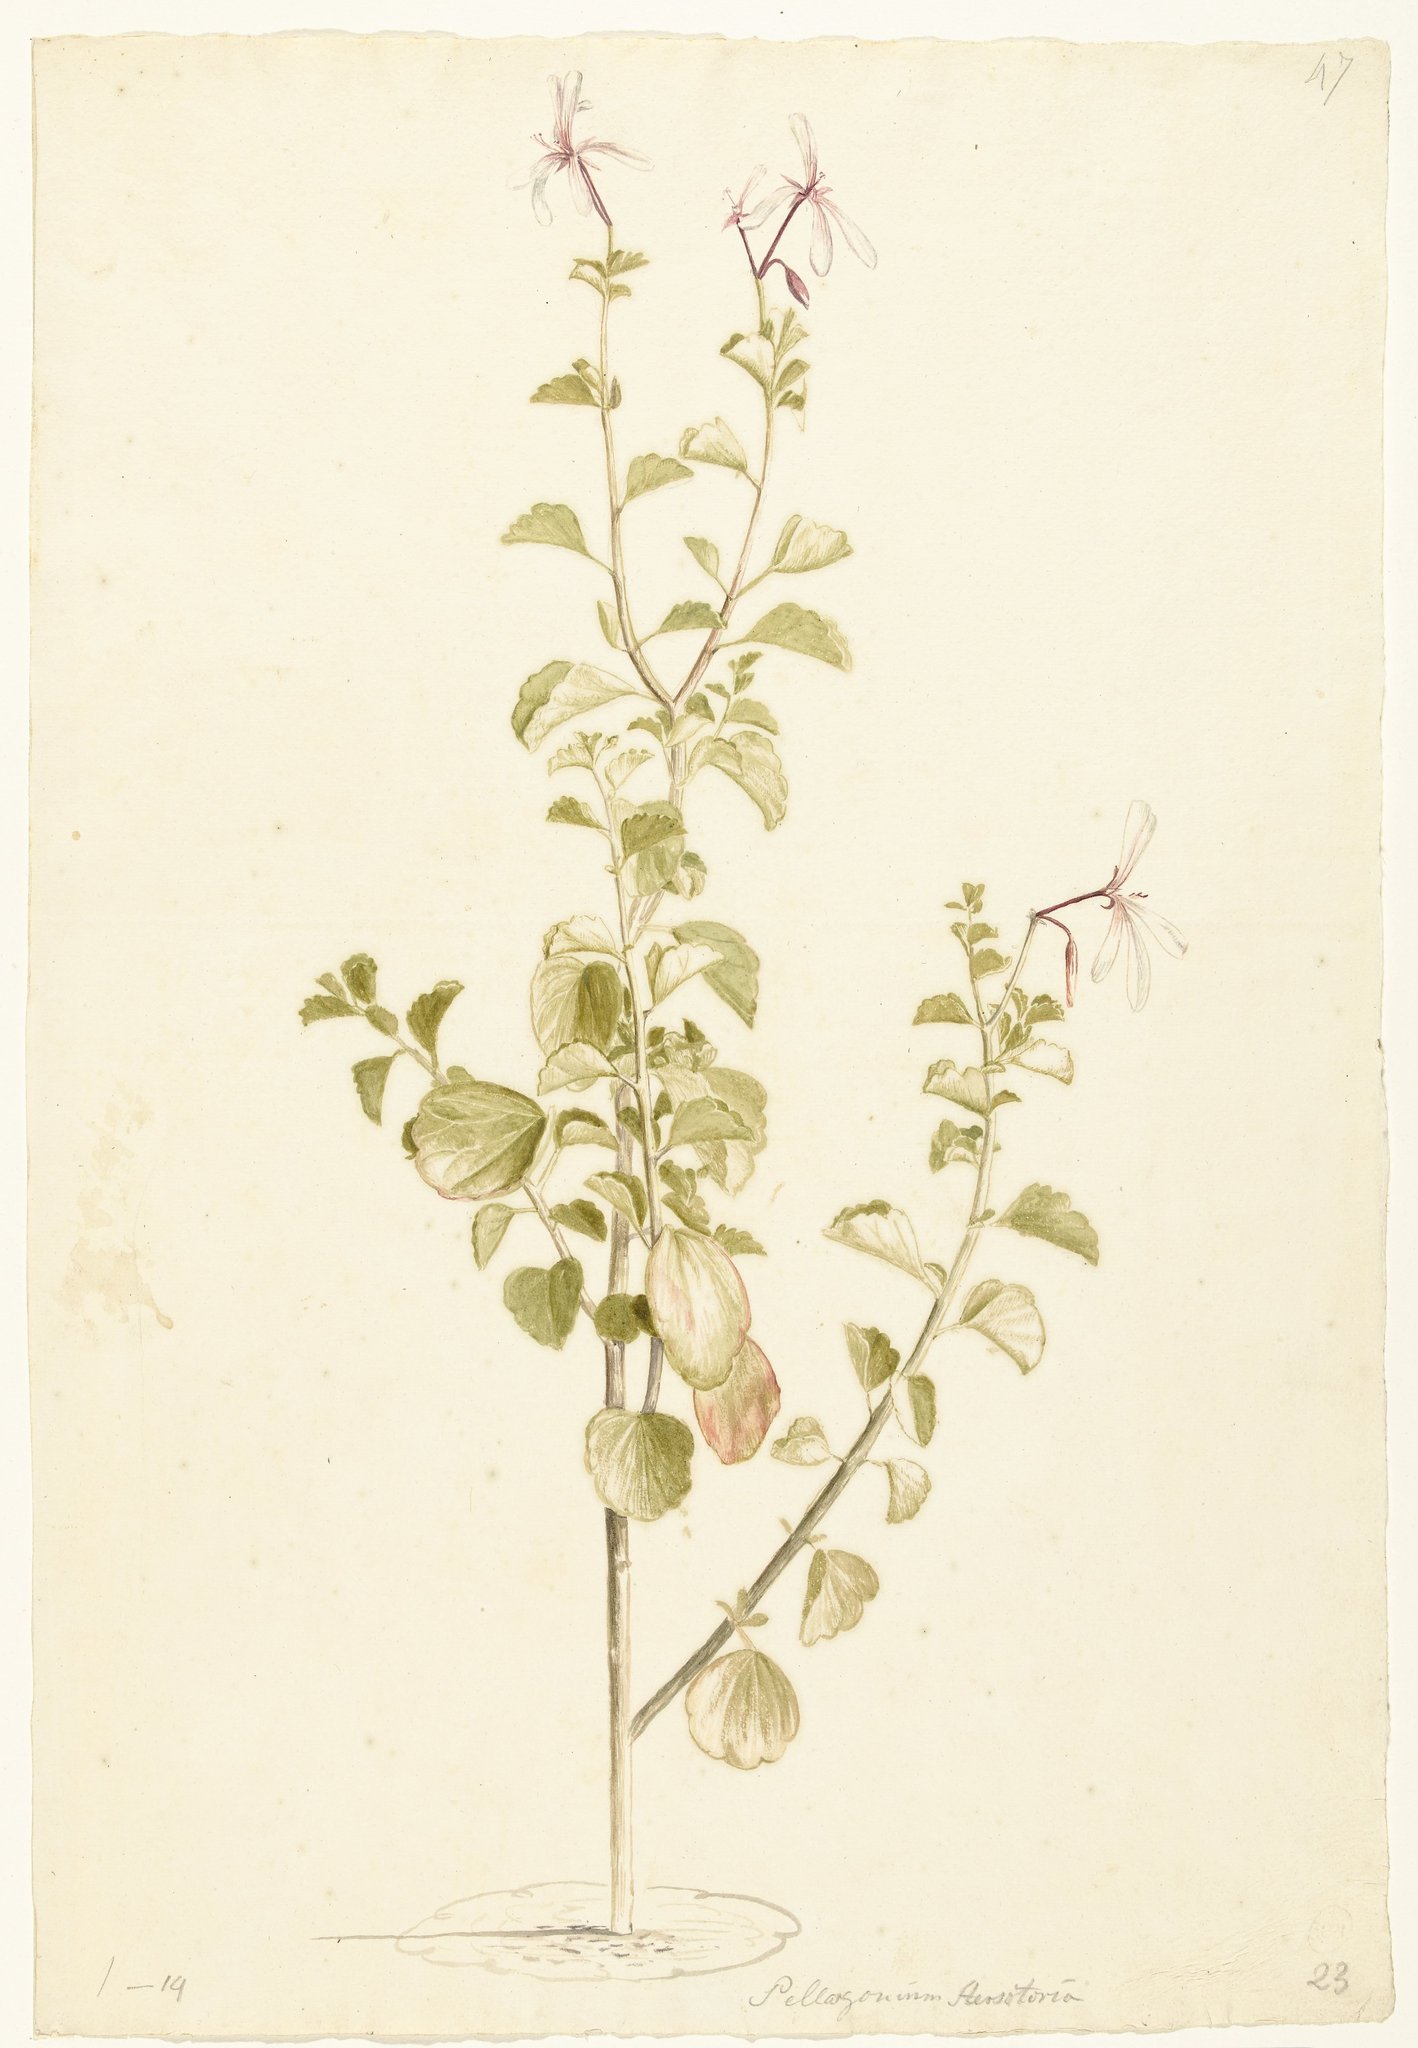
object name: watercolor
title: Bloeiende Pelargonium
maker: laurens vincentsz. van der vinne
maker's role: draughtsman, print maker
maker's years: 1658-1729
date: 1668-1729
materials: paper, watercolor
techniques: brush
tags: plants and herbs: pelargonium